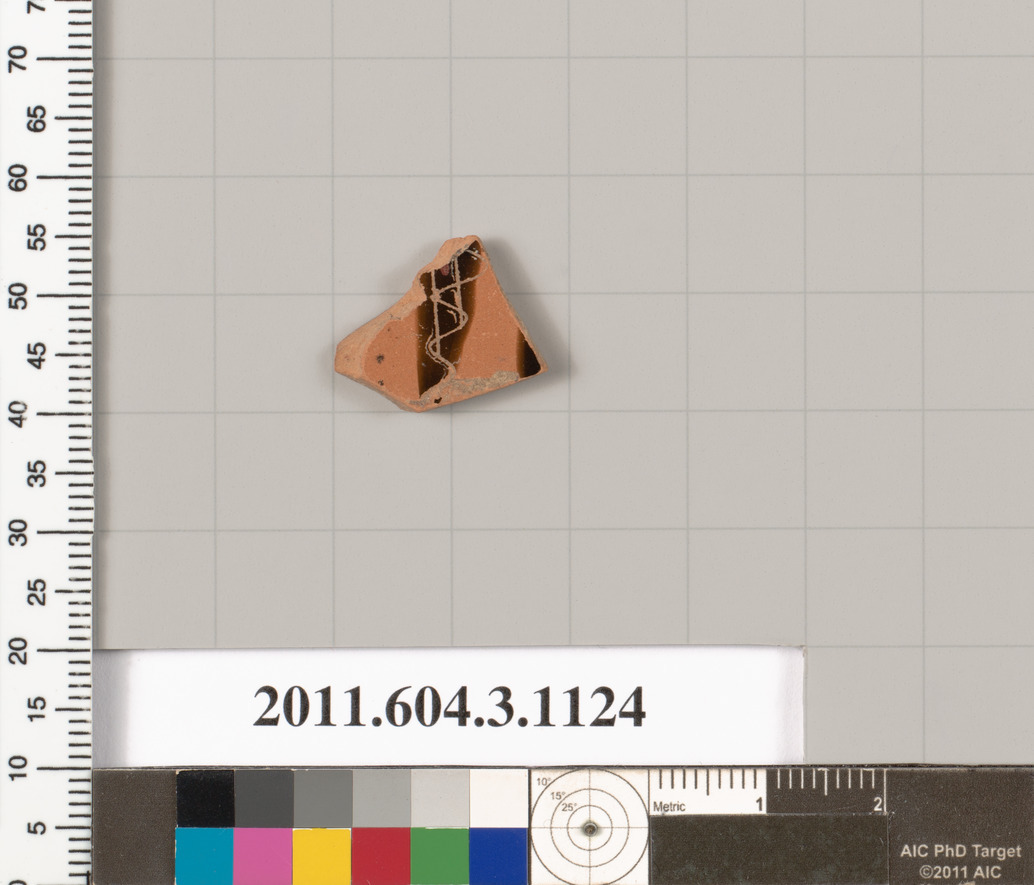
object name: mastoid or kyathos fragment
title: Terracotta fragment of a mastoid (drinking cup with narrow base) or a kyathos (cup-shaped ladle)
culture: greek, attic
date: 534-468 BCE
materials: terracotta